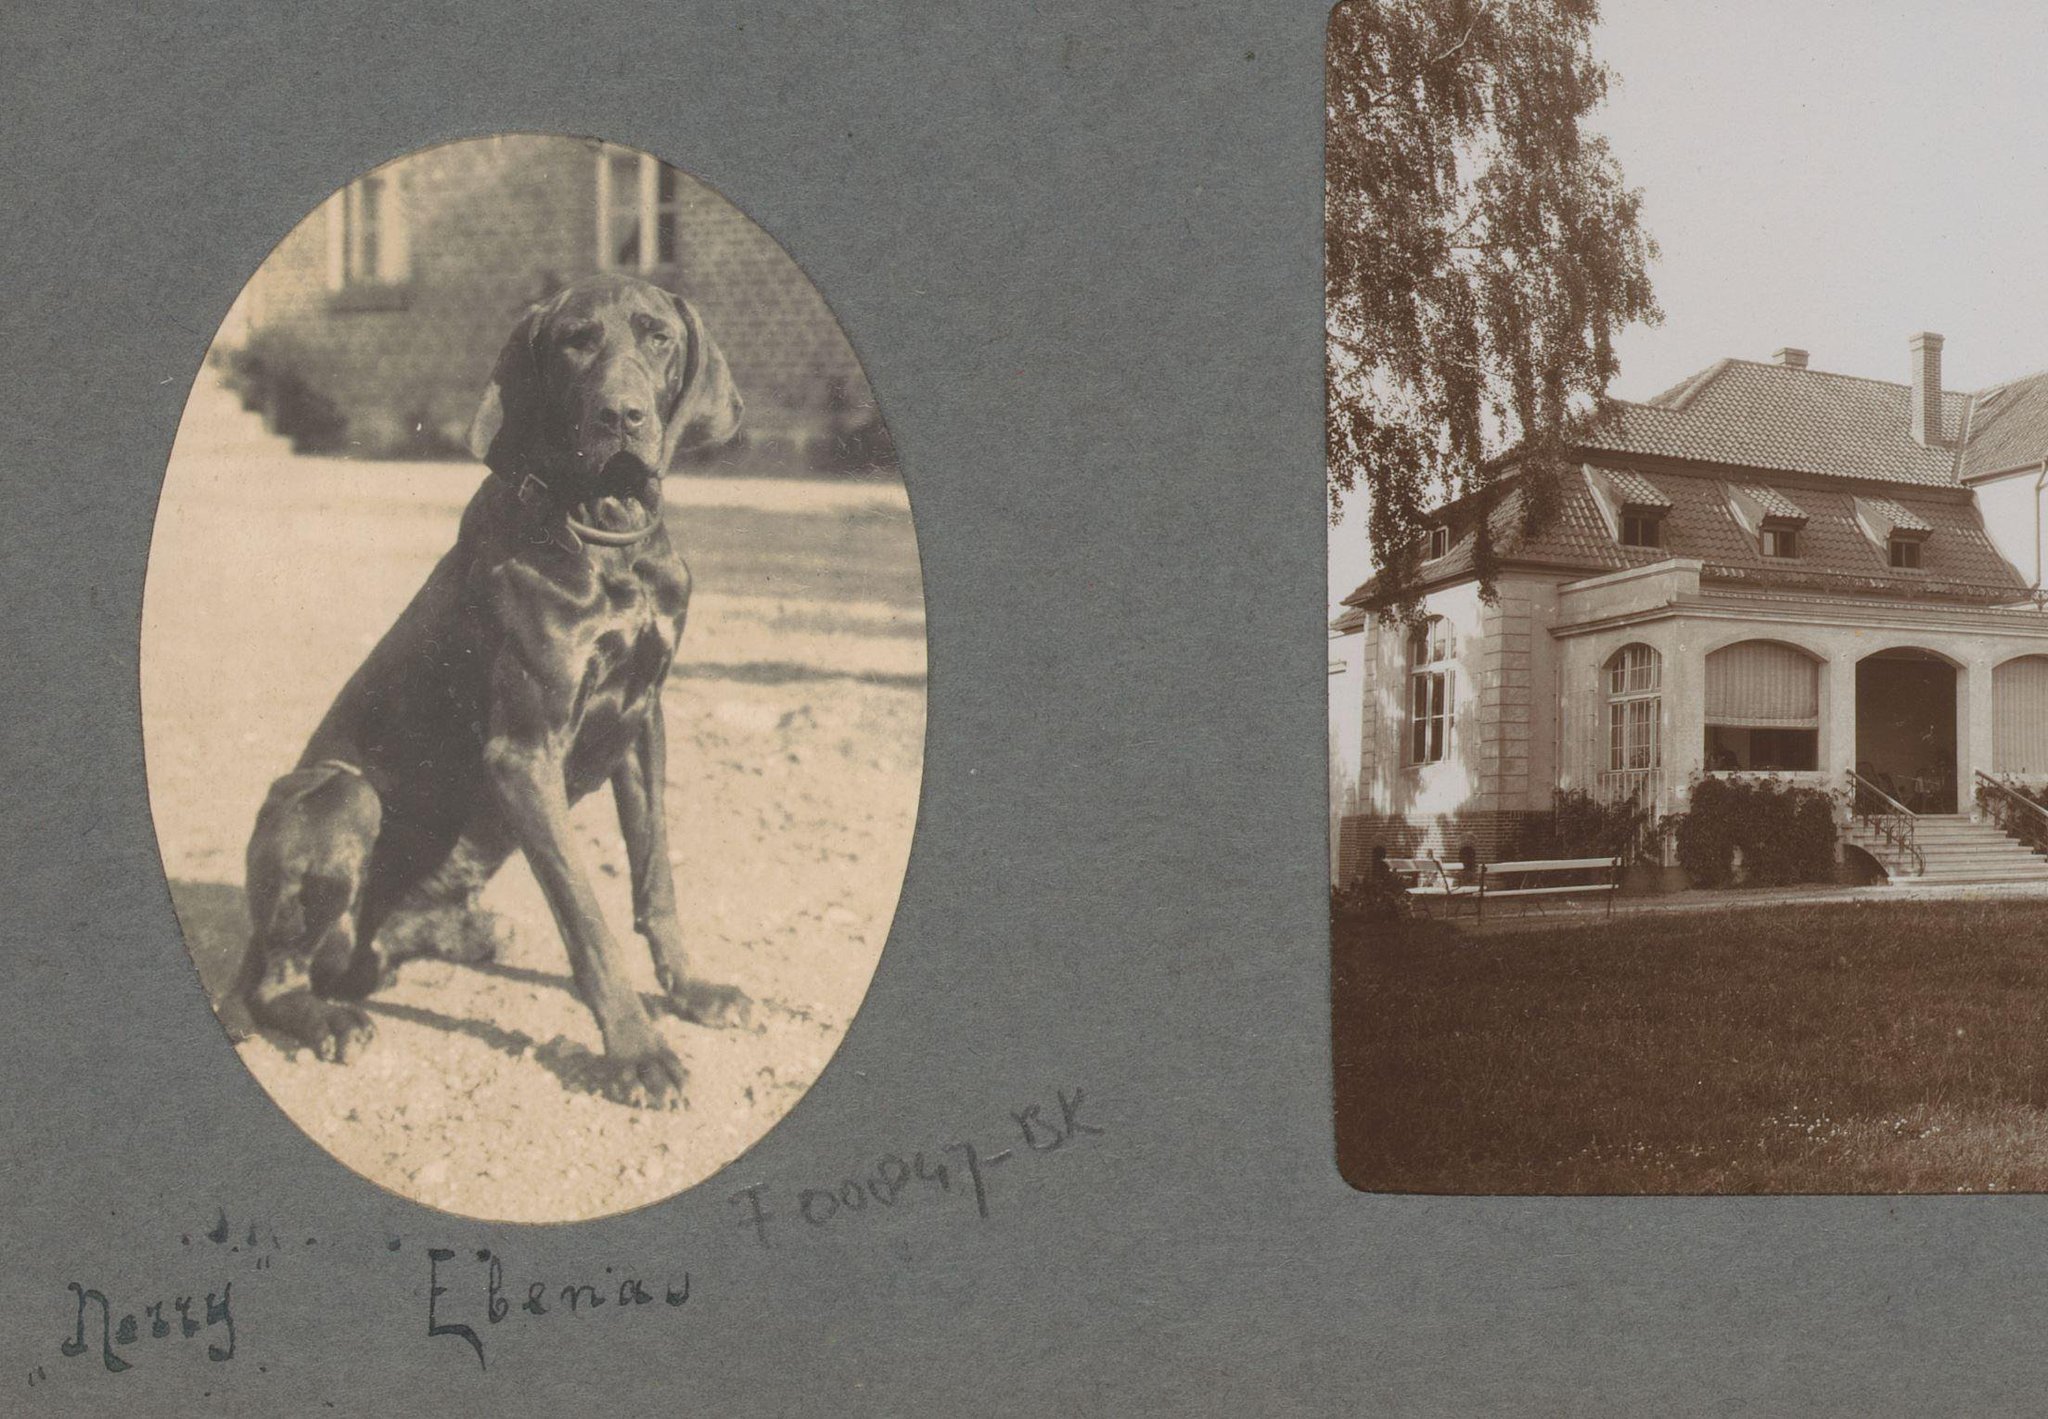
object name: album leaf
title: Zittende hond genaamd Nerry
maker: Anonymous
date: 1906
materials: cardboard, paper, photographic support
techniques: gelatin silver print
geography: ebenau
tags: dog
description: Onderdeel van Reisalbum van een Nederlandse familie met bezienswaardigheden in Europa, Egypte en New York.